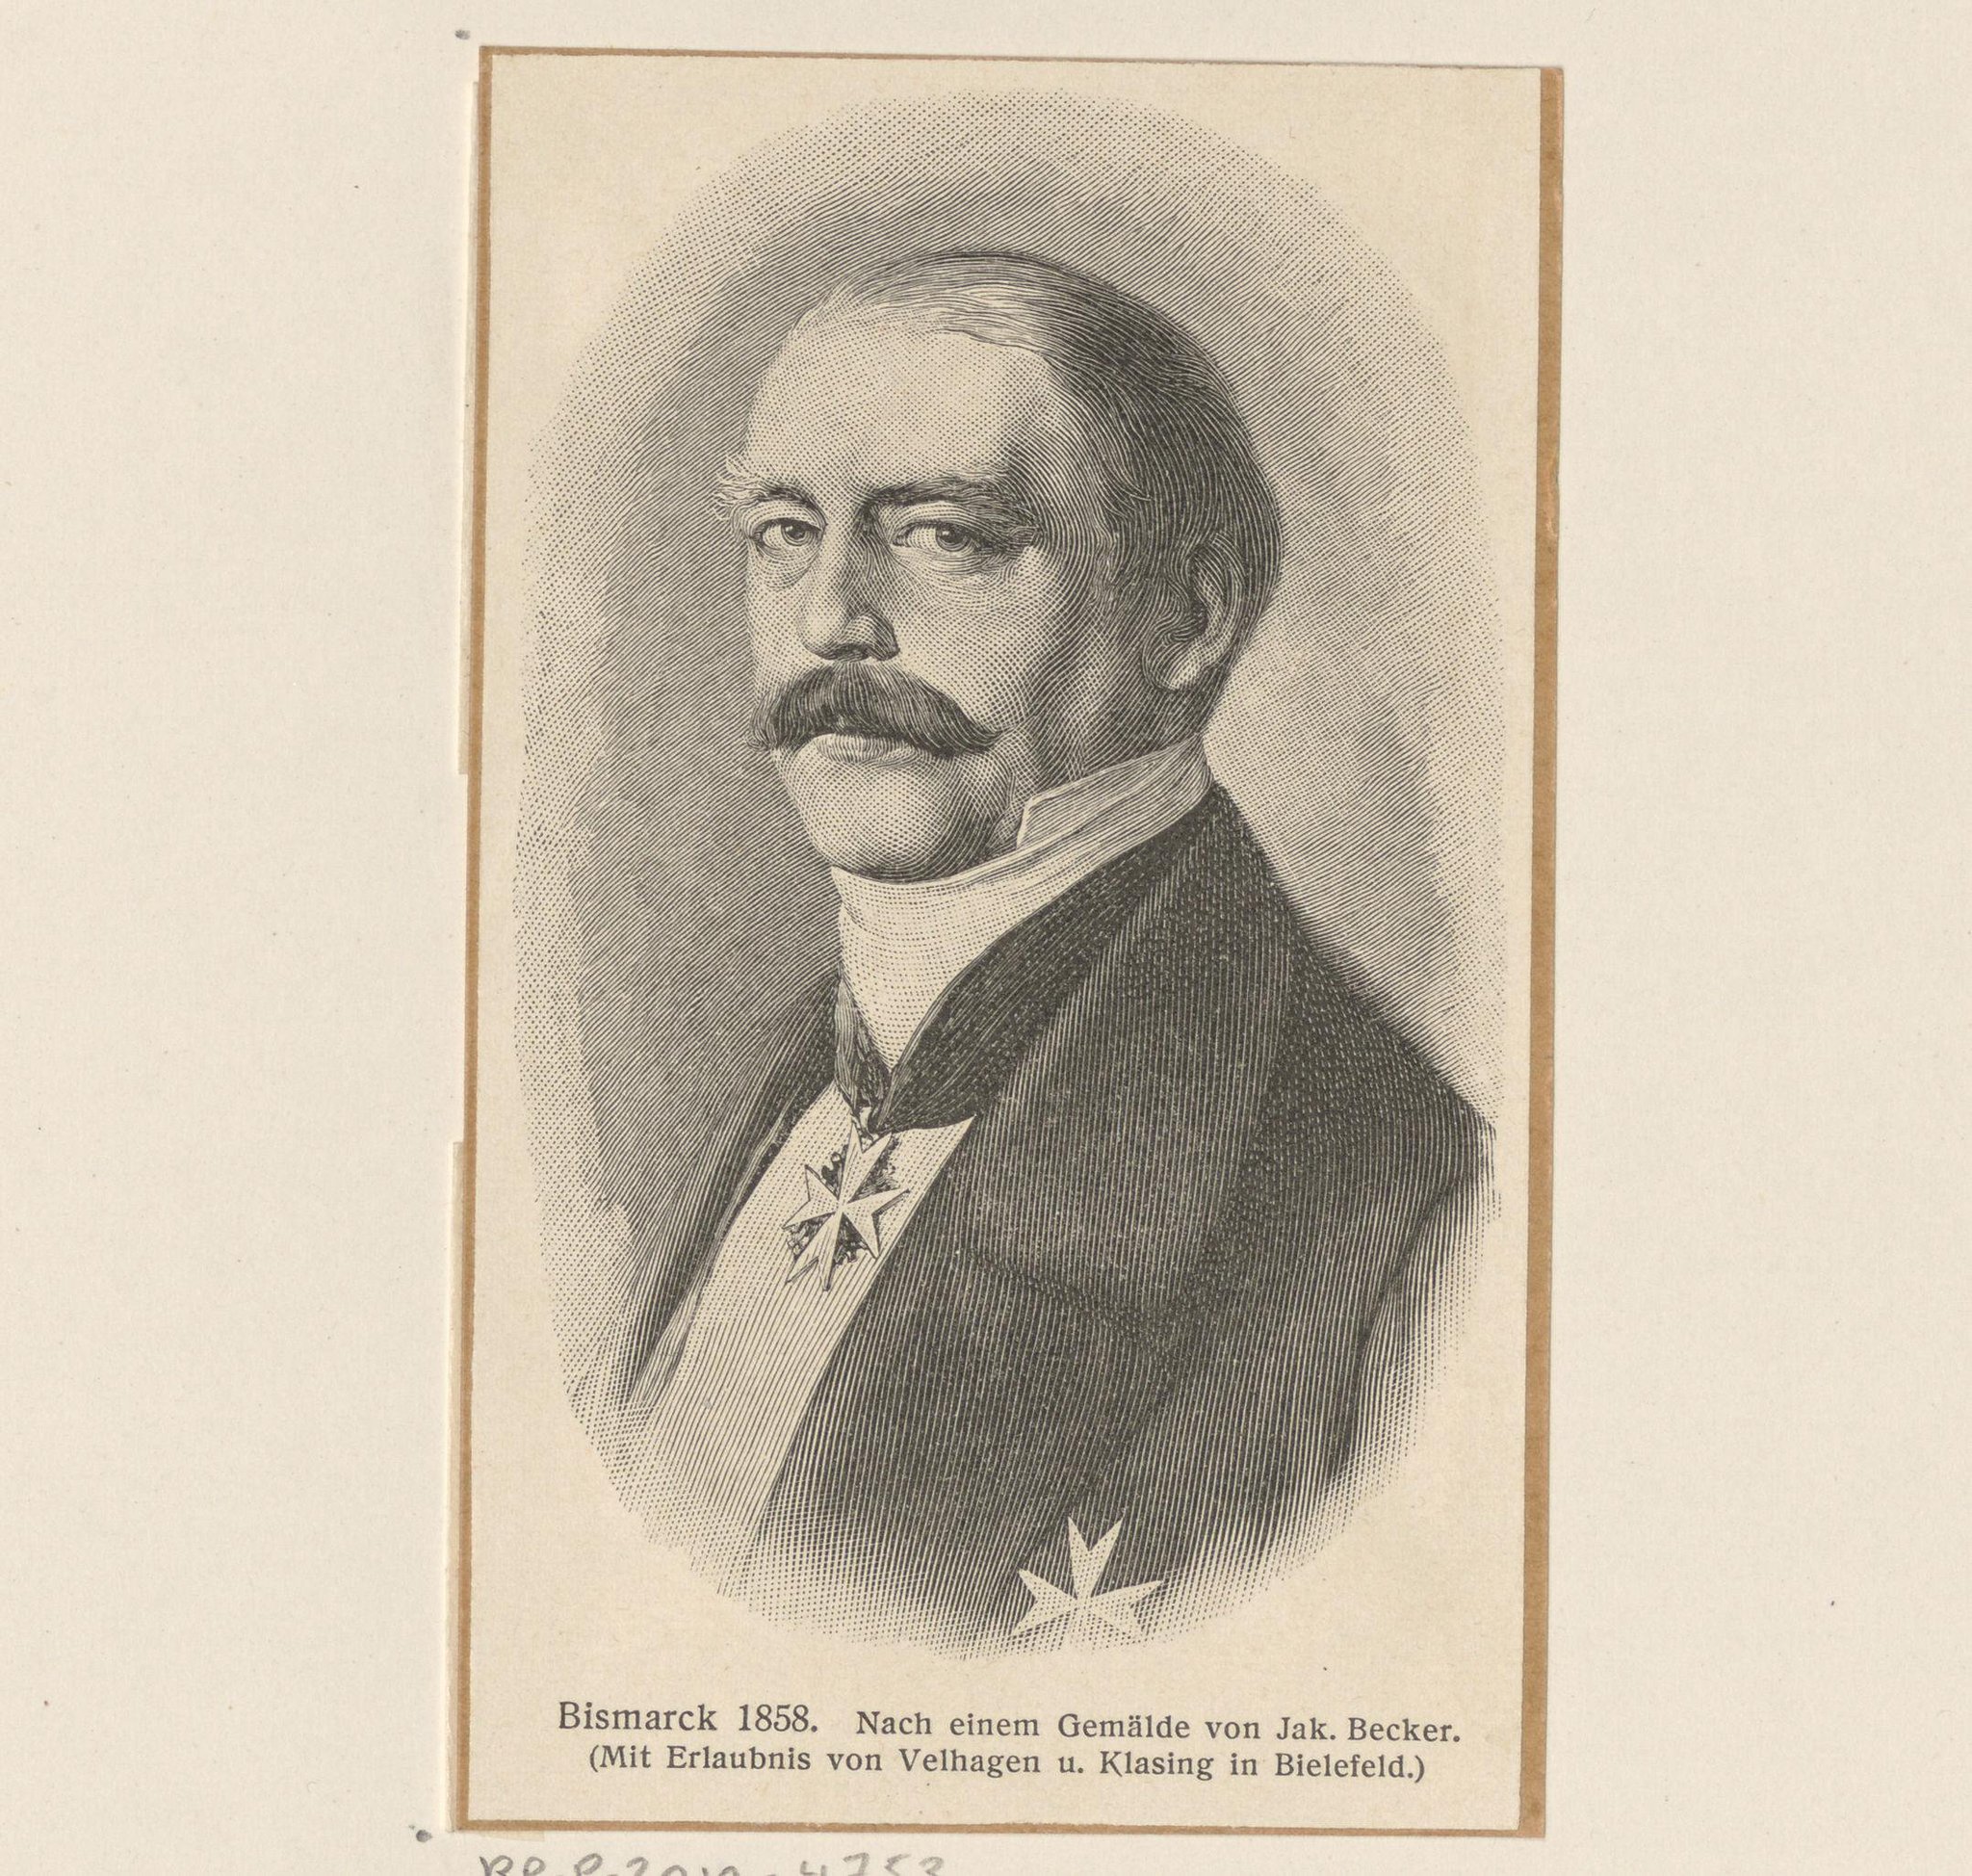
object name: print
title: Portret van Otto von Bismarck op 43-jarige leeftijd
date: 1908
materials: paper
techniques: letterpress printing, engraving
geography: leipzig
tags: historical persons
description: Prent uit: Meyers Grosses Konversations-Lexikon. Ein Nachschlagwerk des allgemeinen Wissens. Leipzig en Wenen: Bibliographisches Institut, 1908, dl. 2.